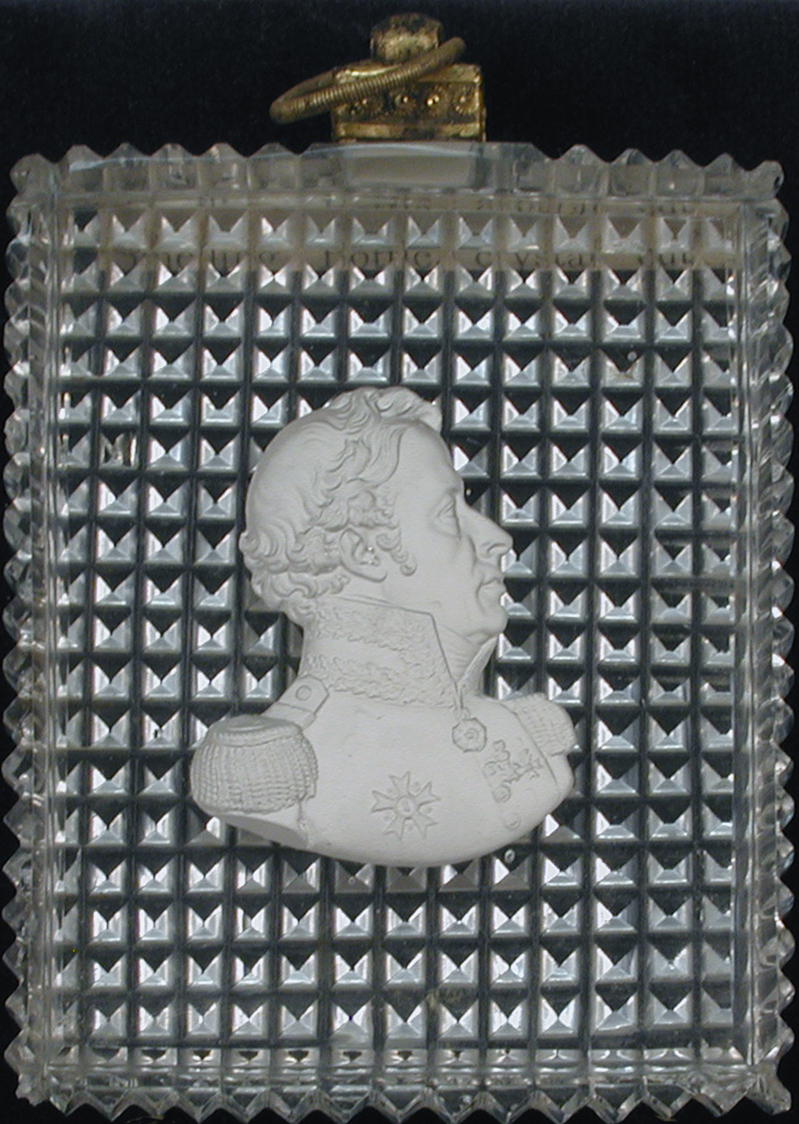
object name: medallion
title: Jacques Etienne Joseph Alexandre MacDonald (1765–1840), duc de Tarente and Maréchal de France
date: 1815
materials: ceramic, gilt bronze, glass, paste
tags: men,profiles